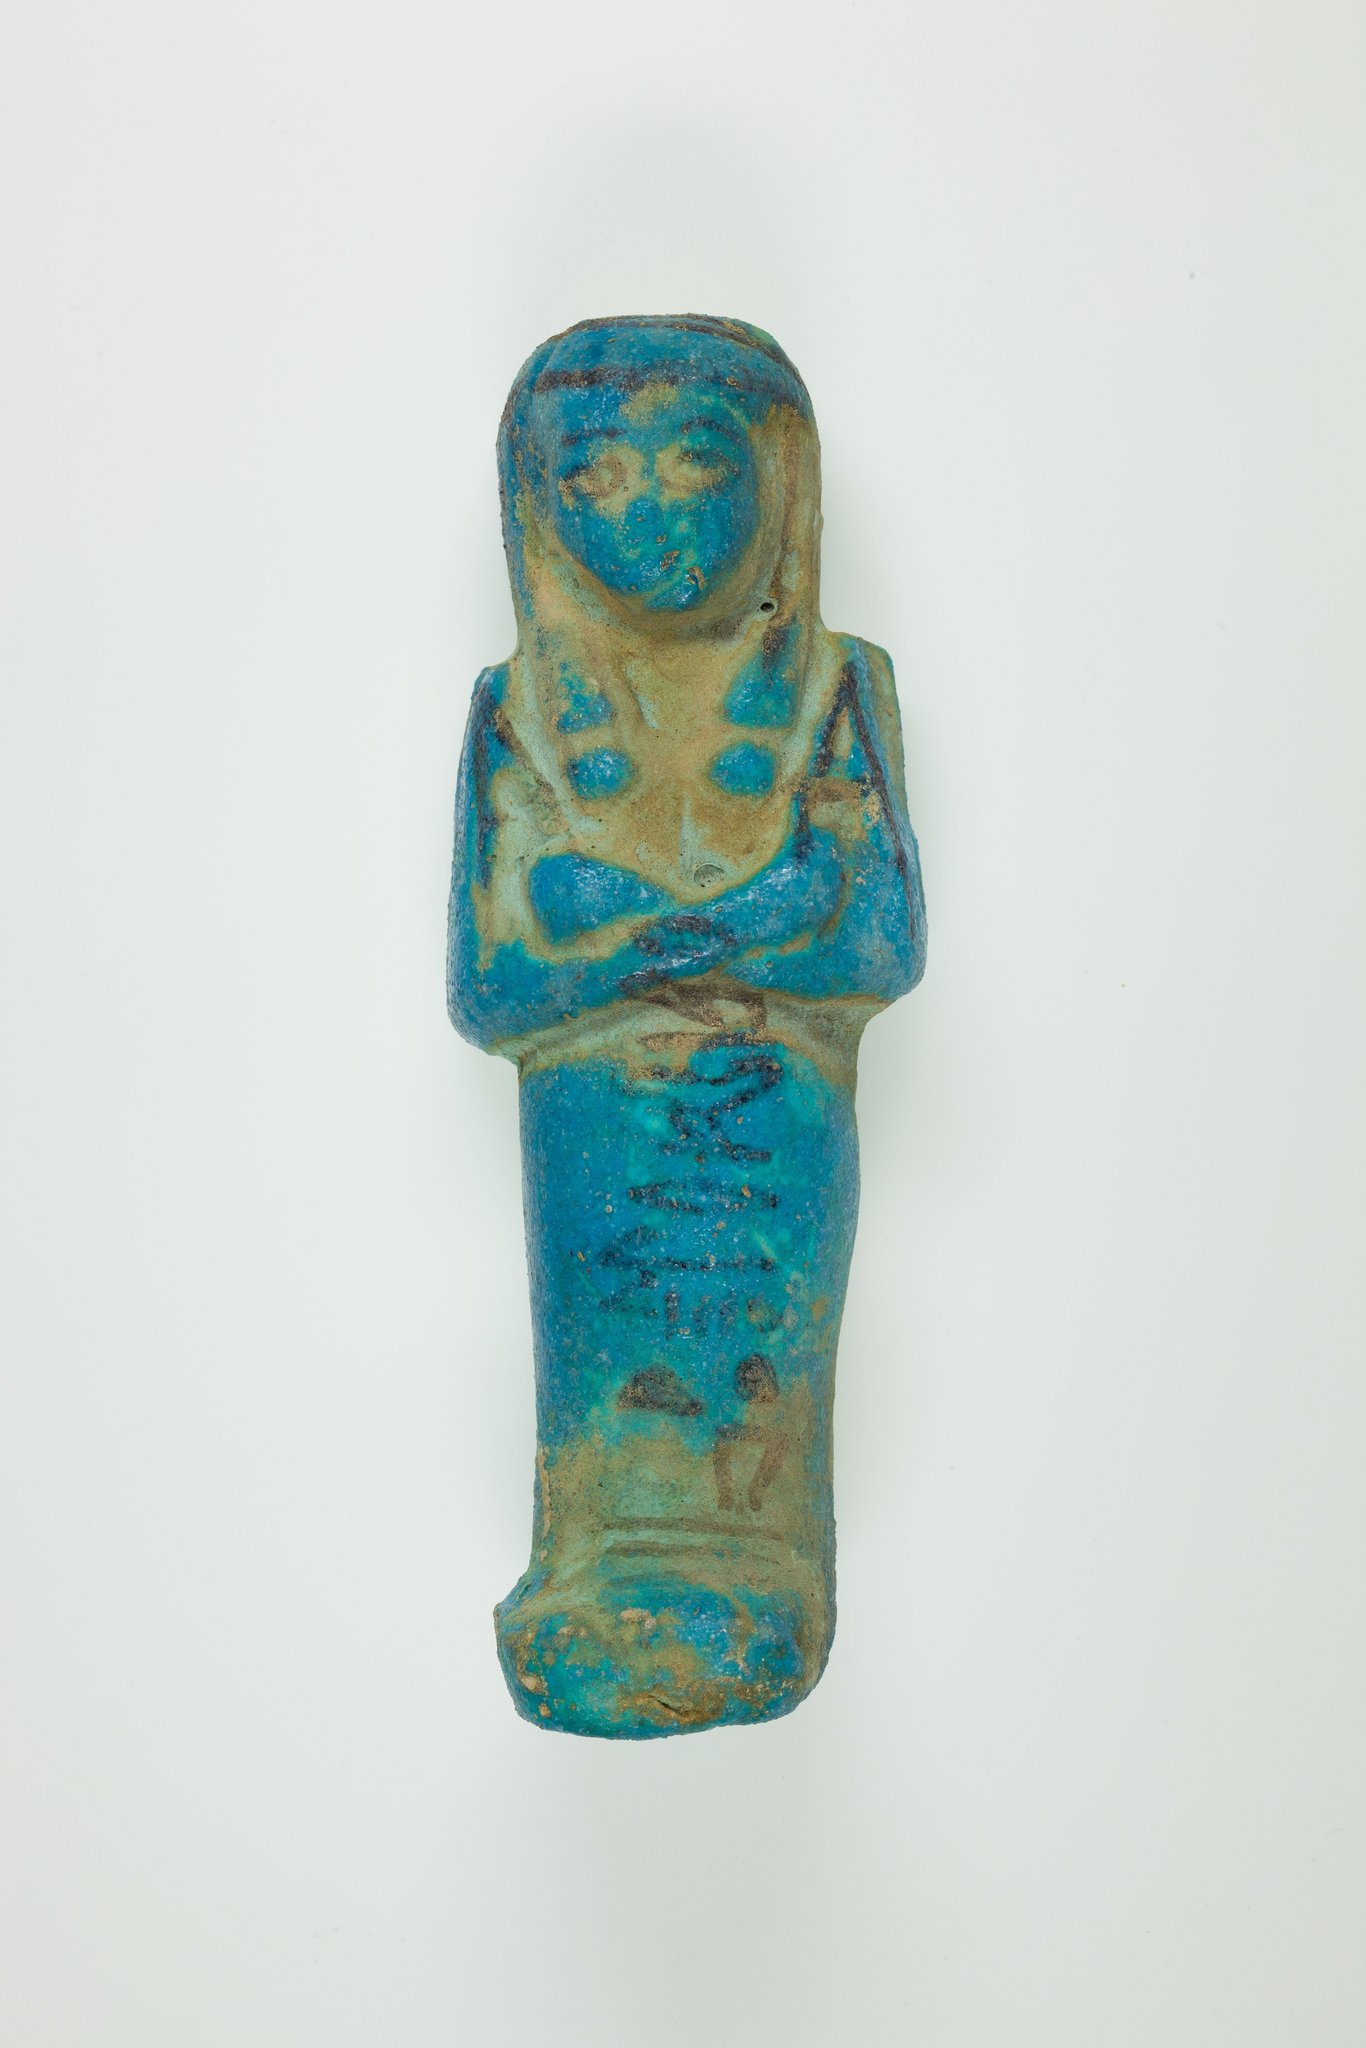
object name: worker shabti, henettawy c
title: Worker Shabti of Henettawy (C), Daughter of Isetemkheb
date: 990-970 BCE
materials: faience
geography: egypt